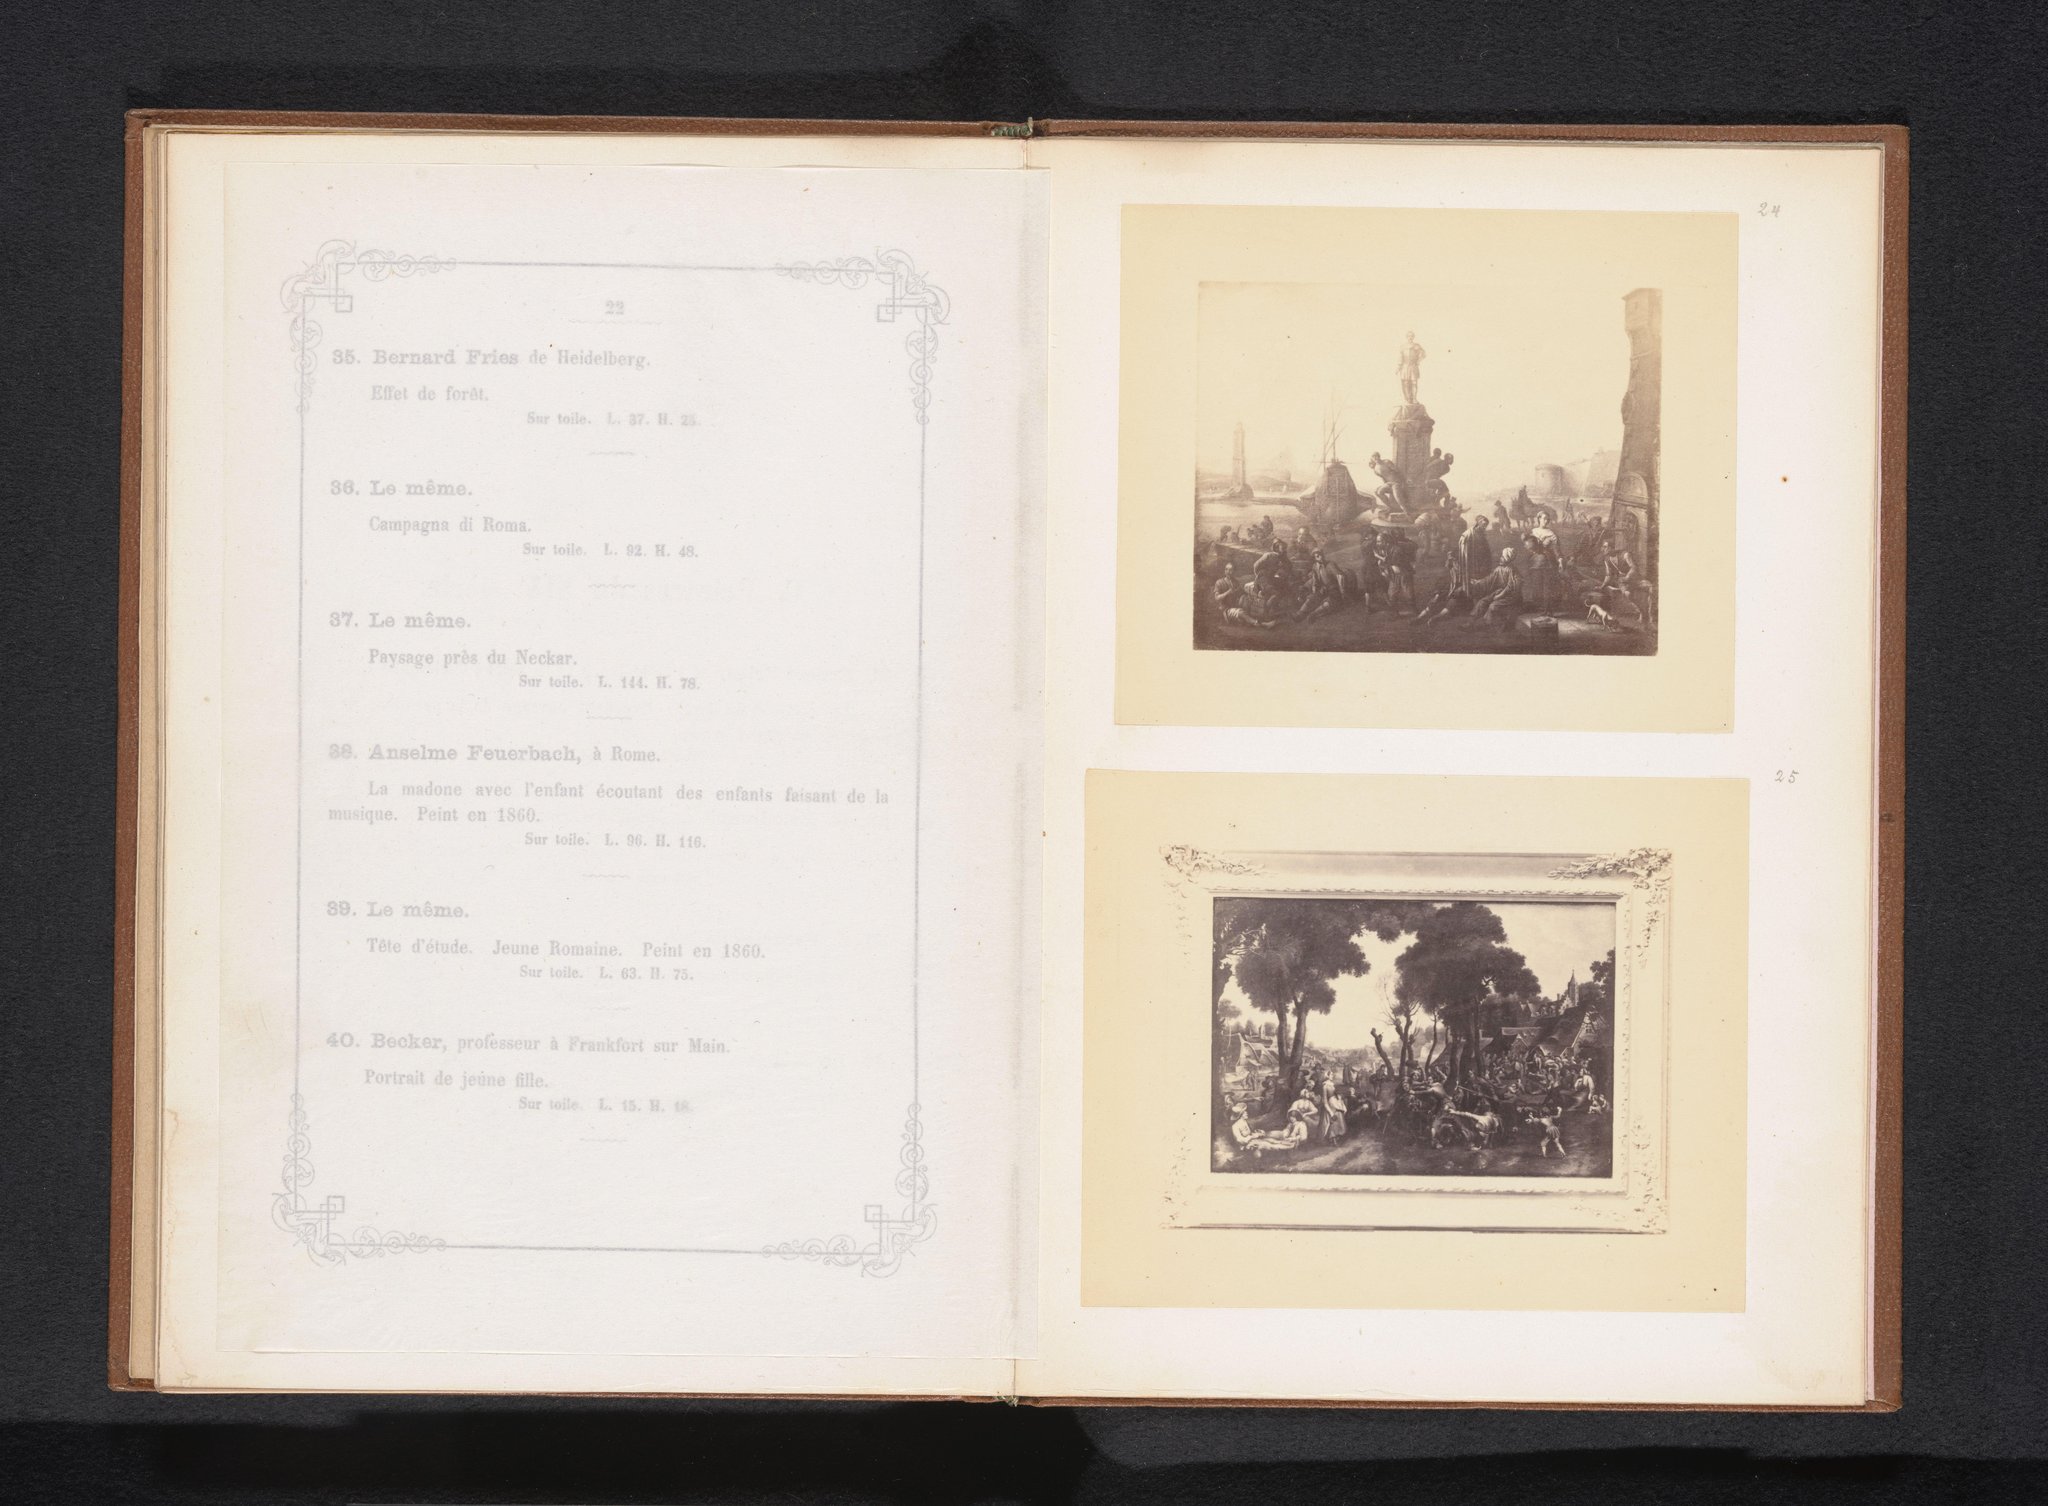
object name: reproduction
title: Fotoreproducties van een gezicht op een haven, mogelijk door Johannes Lingelbach en een genretafereel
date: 1856-1866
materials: photographic support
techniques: albumen print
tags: picture, painting